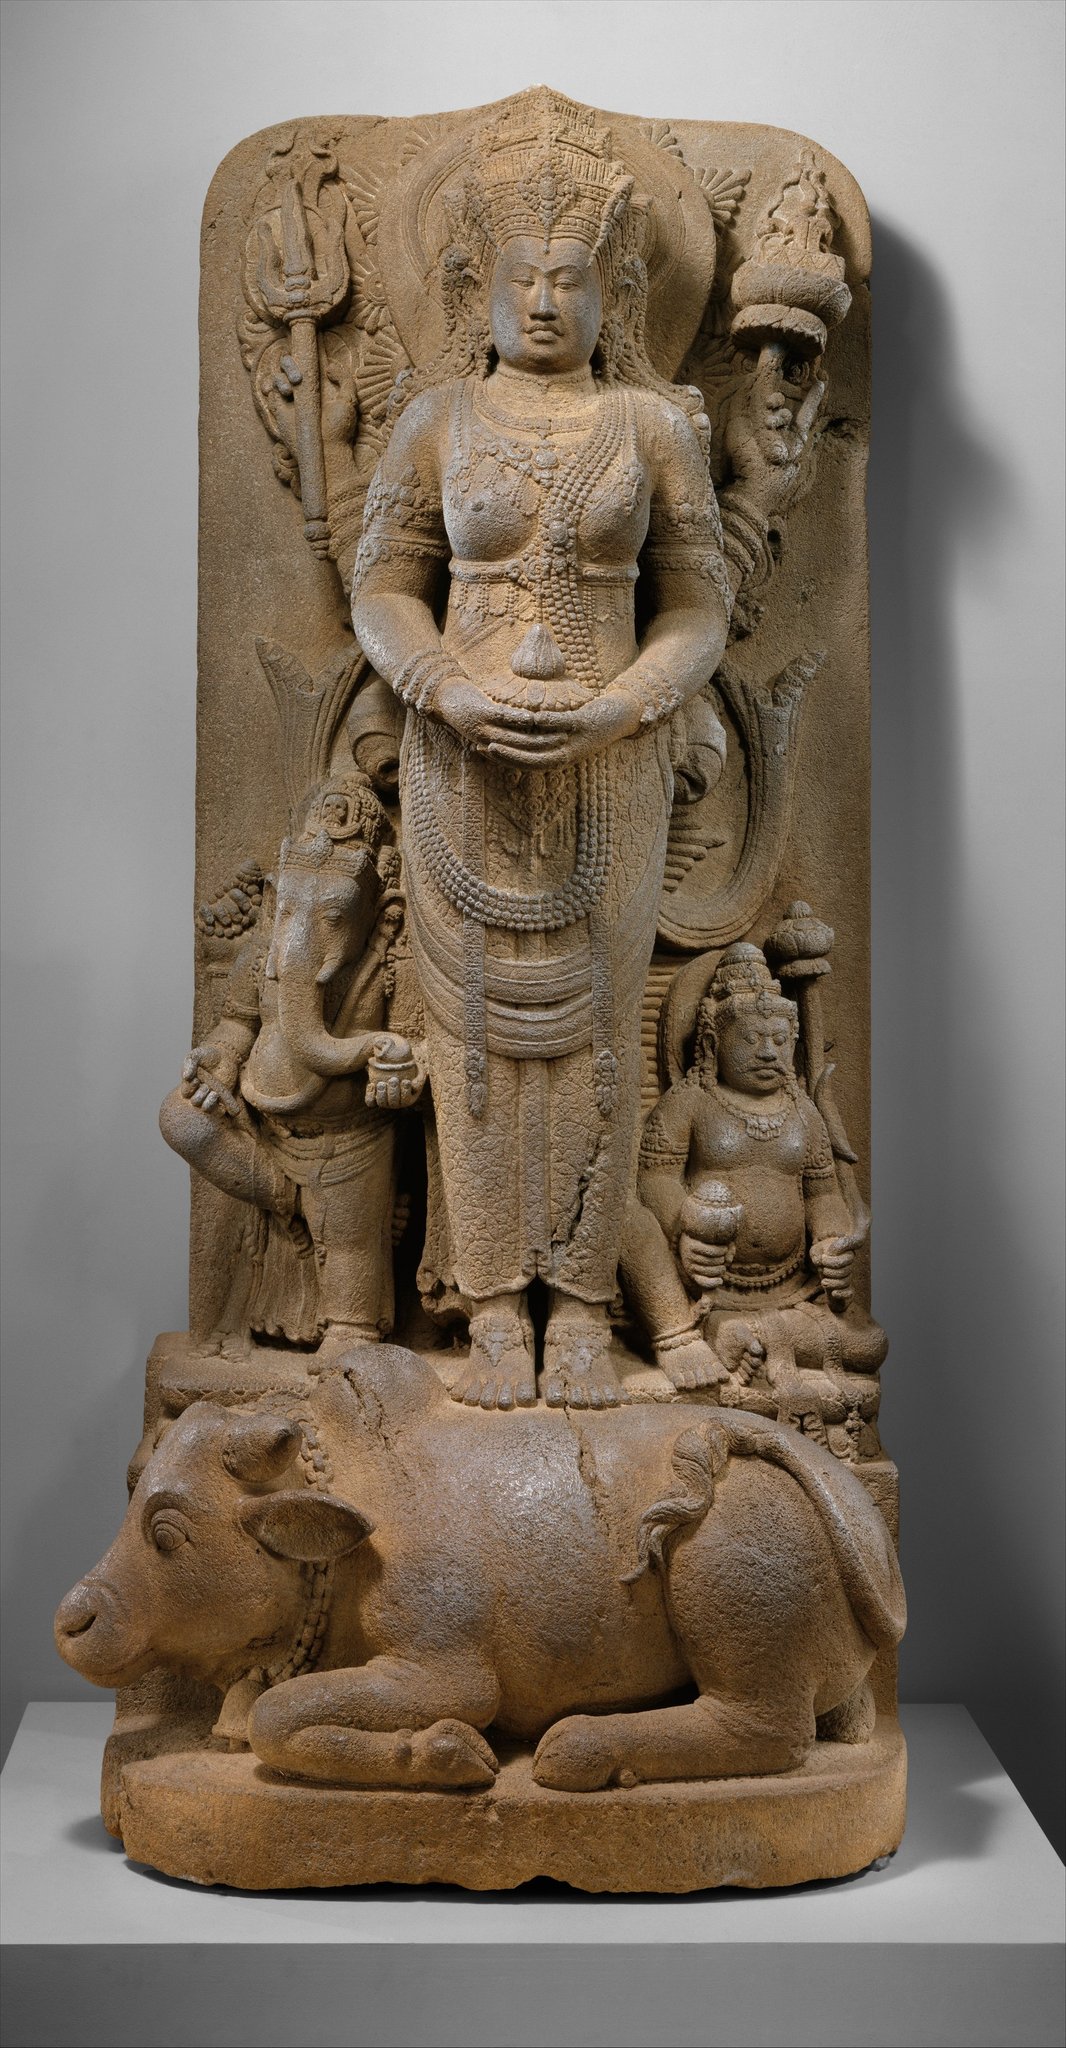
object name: figure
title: Posthumous Portrait of a Queen as Parvati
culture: indonesian, javanese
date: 1301-1400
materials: stone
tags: bulls,ganesha,parvati,hinduism